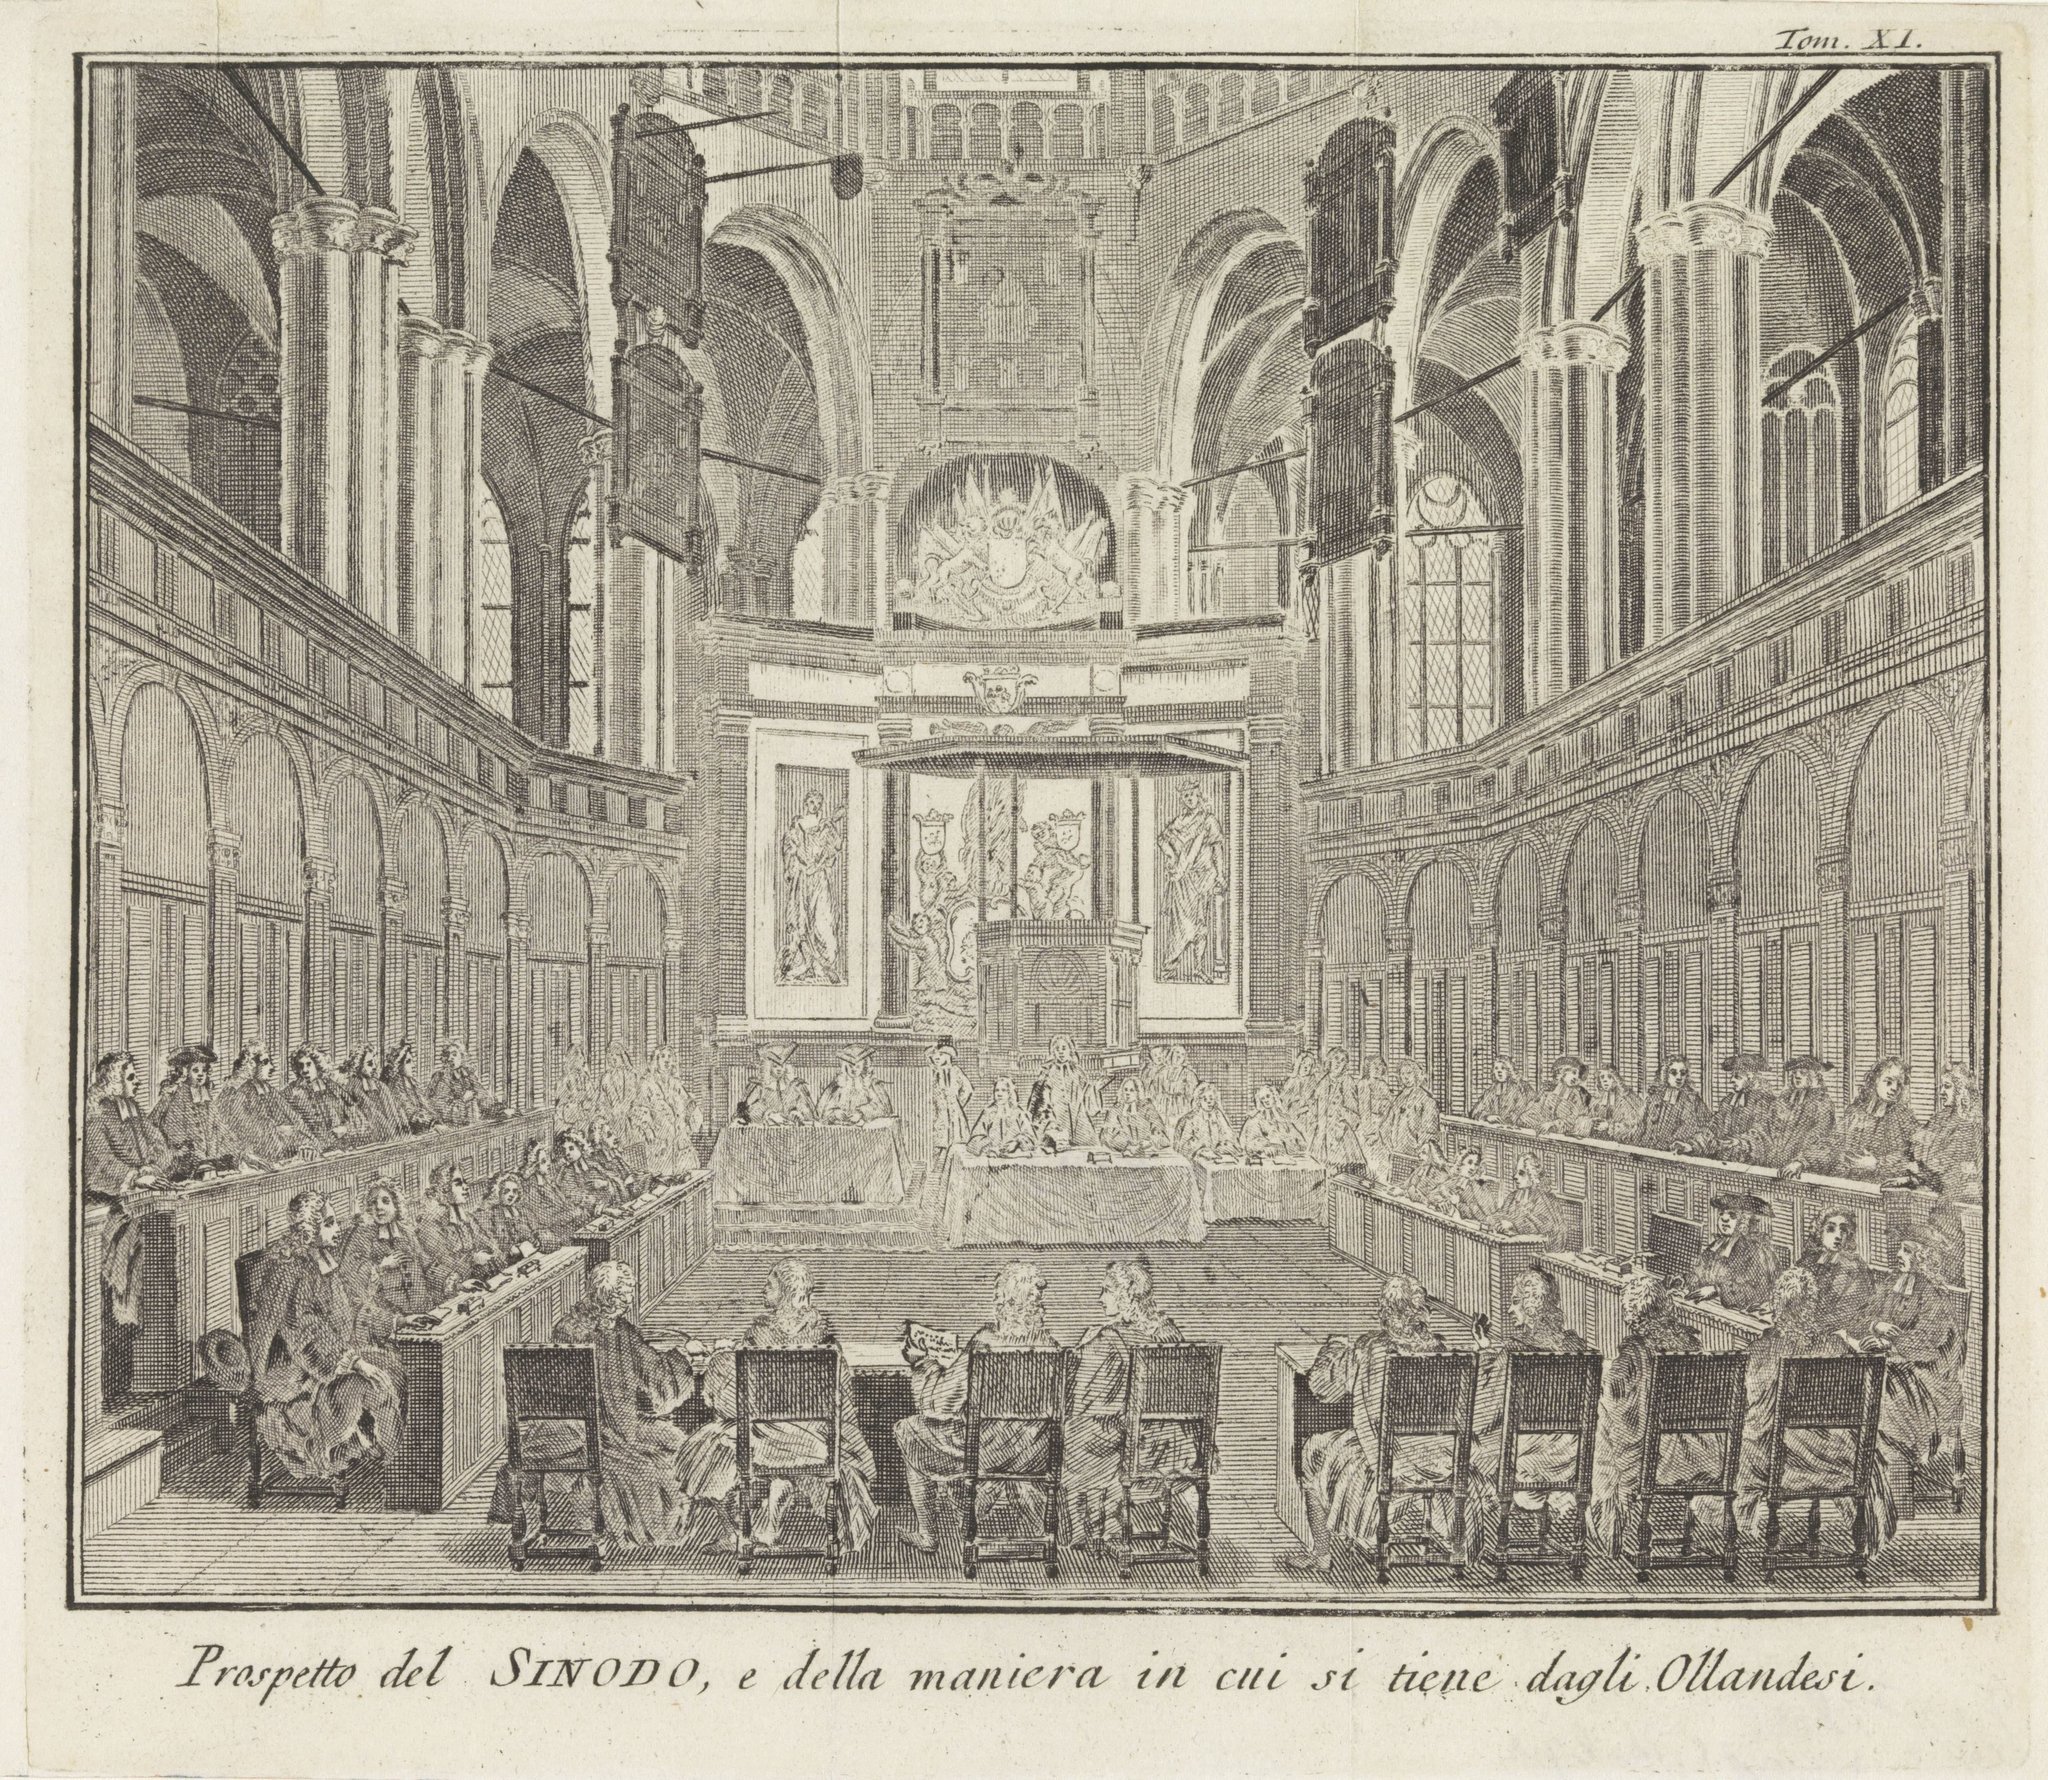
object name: print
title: Een Synode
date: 1742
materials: paper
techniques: etching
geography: italy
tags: council, synod ~ roman catholic church, dordrecht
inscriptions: collector's mark: Lugt 2228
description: Prent gebruikt voor Salmon, Thomas. Lo stato Presente di tutti i Paesi del Mondo... volume XI, Delle sette provincie unite, Dei paesi Bassi, Degli Svizzeri, Grigioni, e loro alleati. Venetië: Giambattista Albrizzi, 1742.